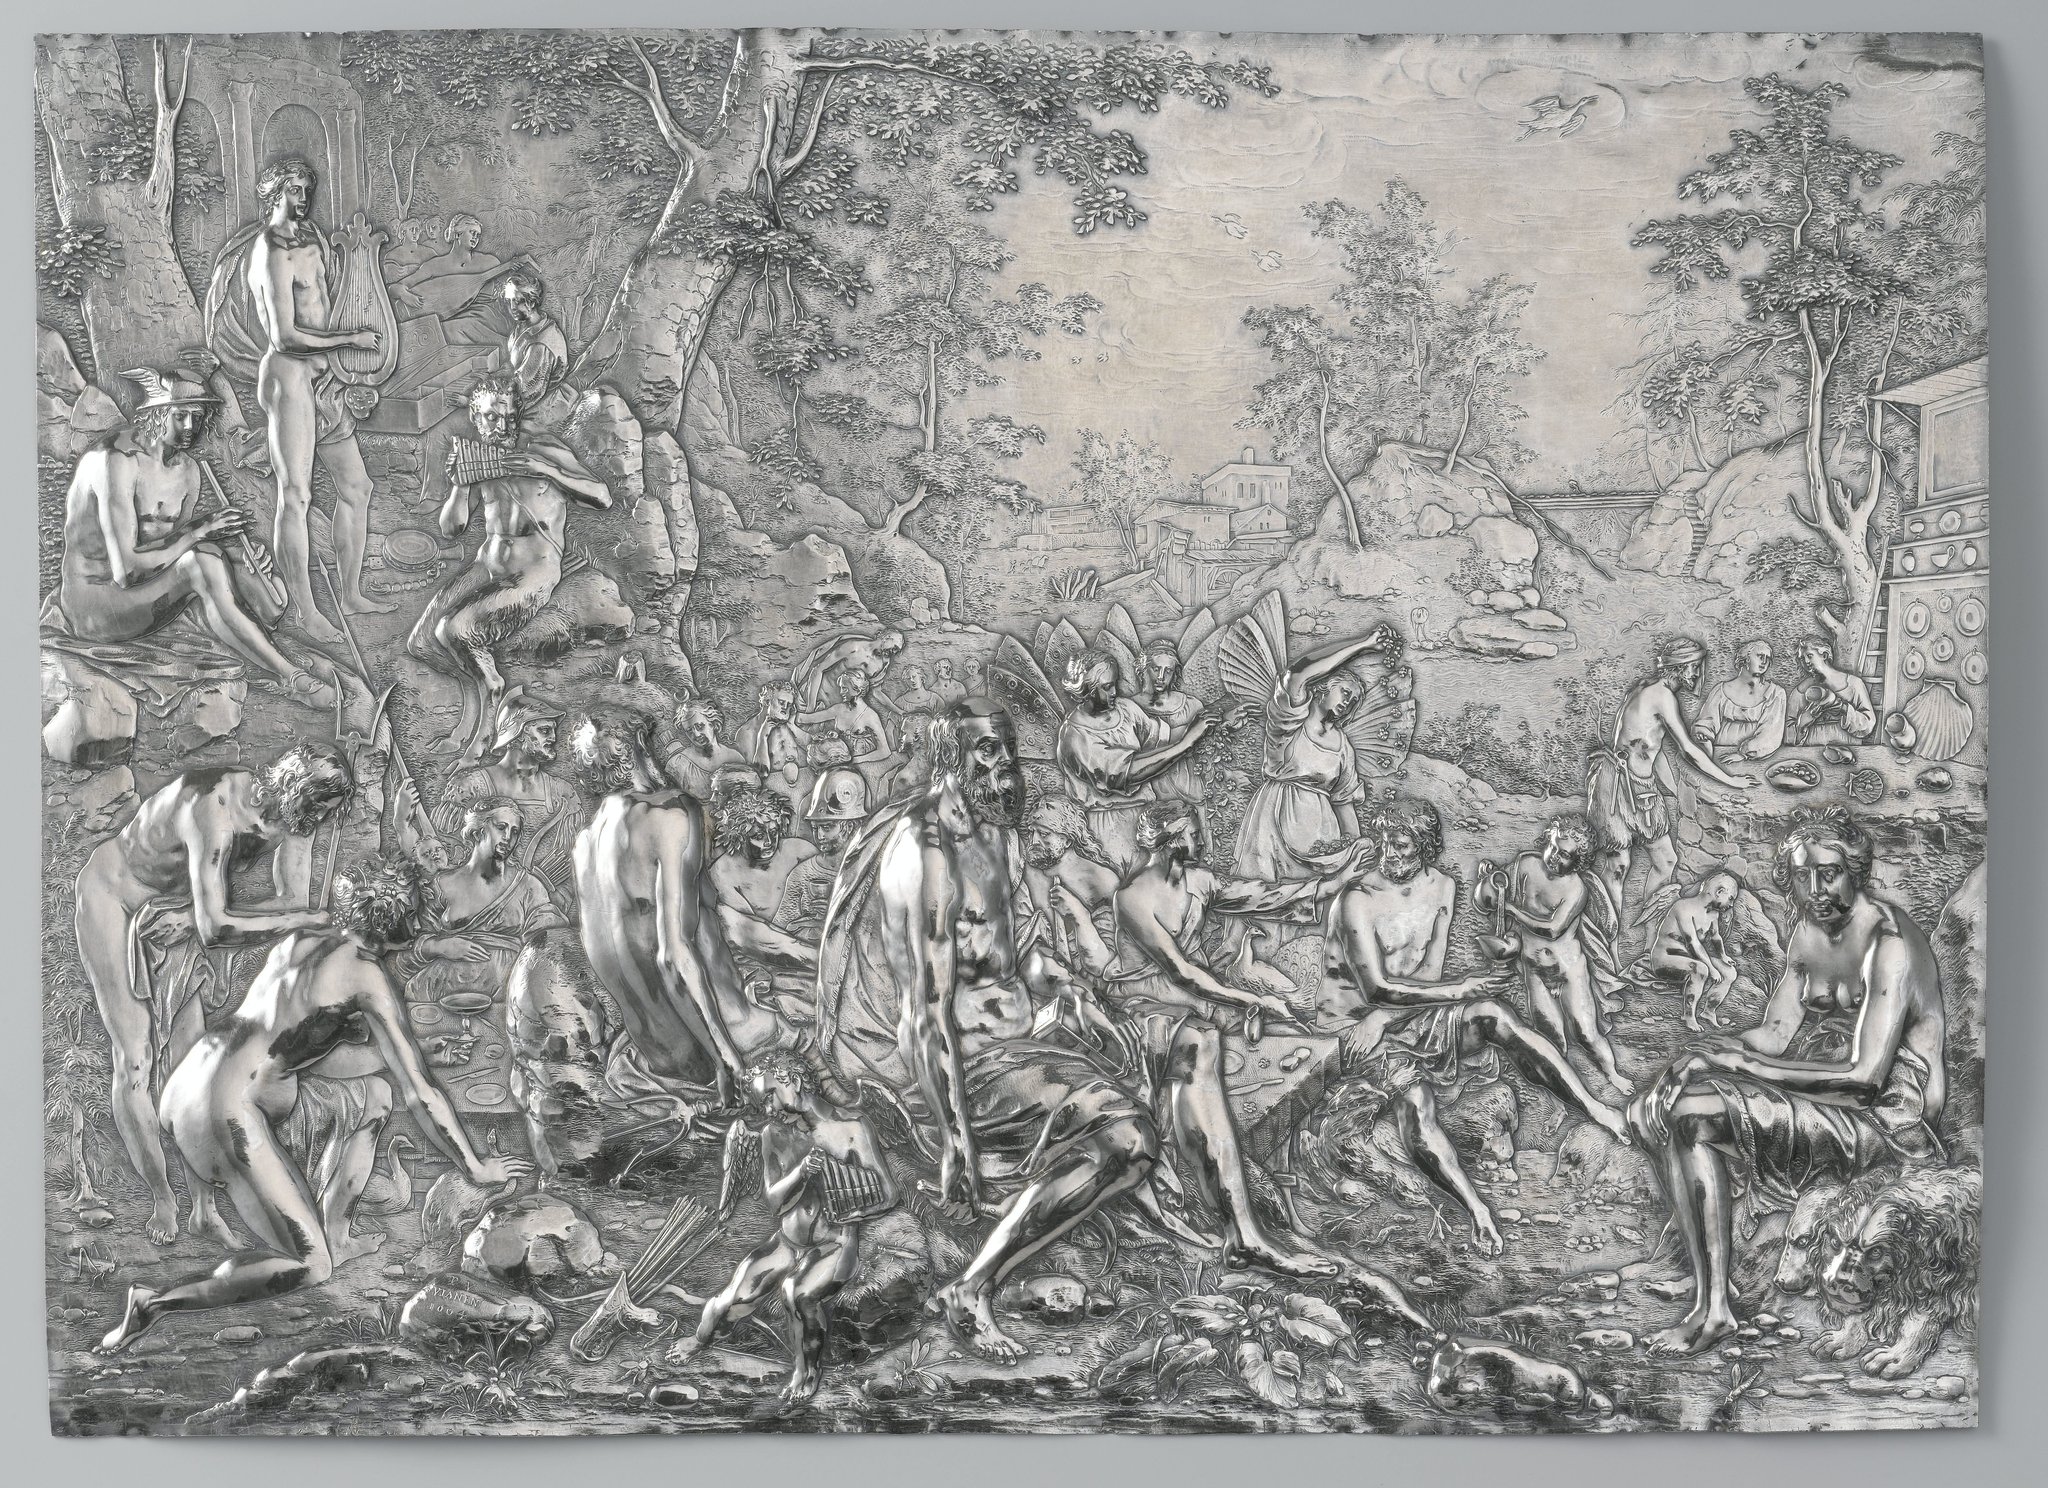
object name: plaque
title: The Feast of the Gods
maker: paulus willemsz. van vianen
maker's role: draughtsman, jeweler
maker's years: 1570-1614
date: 1604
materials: silver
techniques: repoussé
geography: prague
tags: banquets, feasts of the gods (outdoors)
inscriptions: date: ‘1604’, monogram: ‘PV’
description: In the centre foreground is the seated figure of Saturn, with a scythe and an hourglass. His wife, Rhea, is at the far right. With their sons Jupiter (ruler of the sky), Pluto (ruler of the underworld) and Neptune (ruler of the sea) and other gods, they partake of a meal, which, however, does not seem in the least bit festive. The gloom cast over this scene clouds our understanding of its meaning.